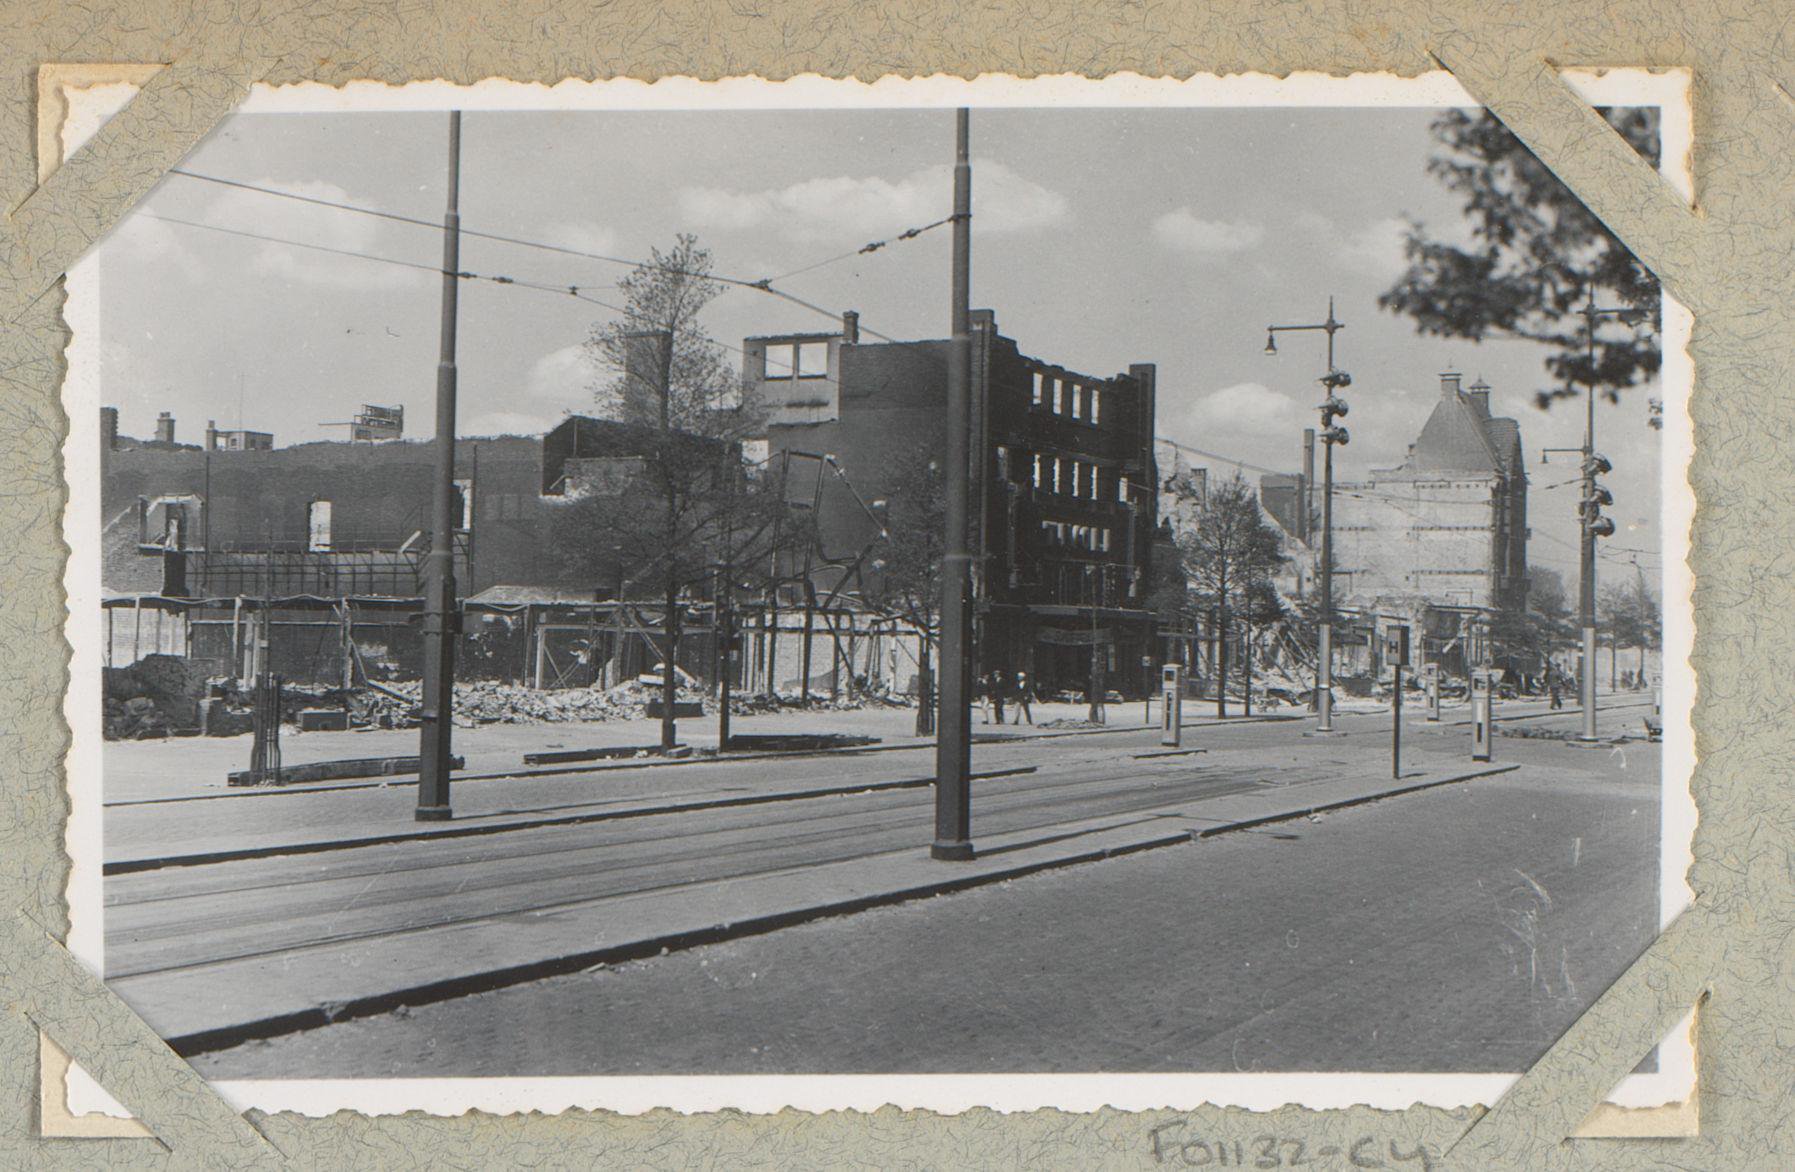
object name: photograph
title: Ruïnes aan de Coolsingel te Rotterdam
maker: j. nolte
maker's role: fotograaf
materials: photographic support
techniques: gelatin silver print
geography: rotterdam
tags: devastated, ruined place or city (~ warfare), street, ruin of a dwelling, house, castle, etc., rotterdam, rotterdam blitz